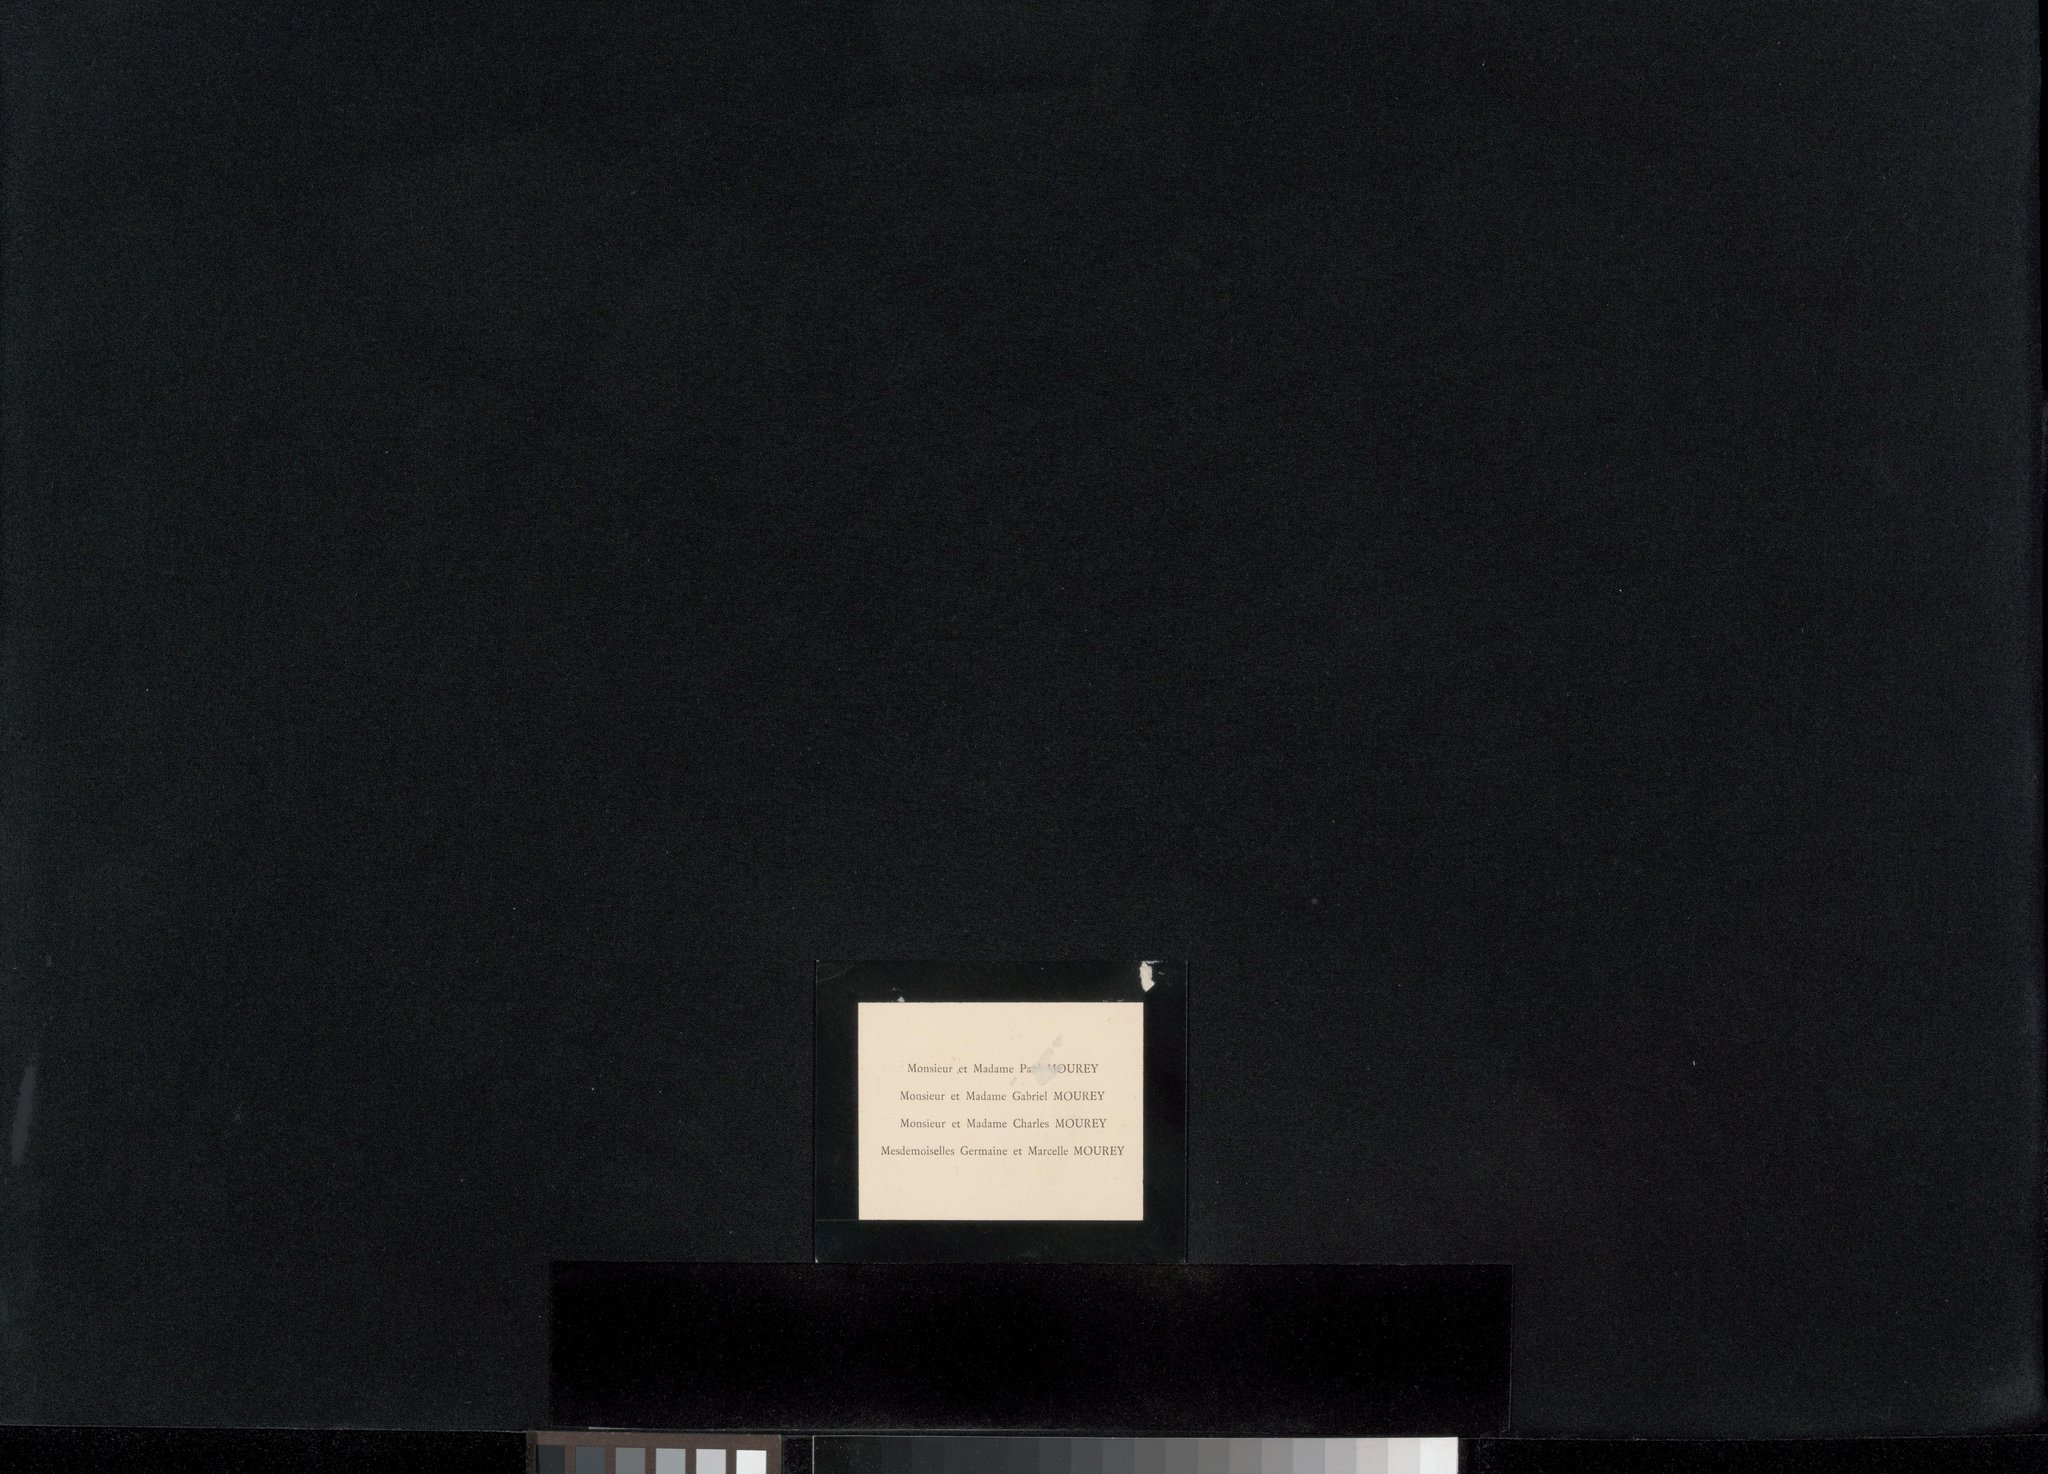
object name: bedankkaart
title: Bedankkaart aan Philip Zilcken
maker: Anonymous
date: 1900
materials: cardboard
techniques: printing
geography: saint-cloud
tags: marseille, gabriel mourey, painter, draughtsman, philip zilcken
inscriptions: collector's mark: ‘RPK’